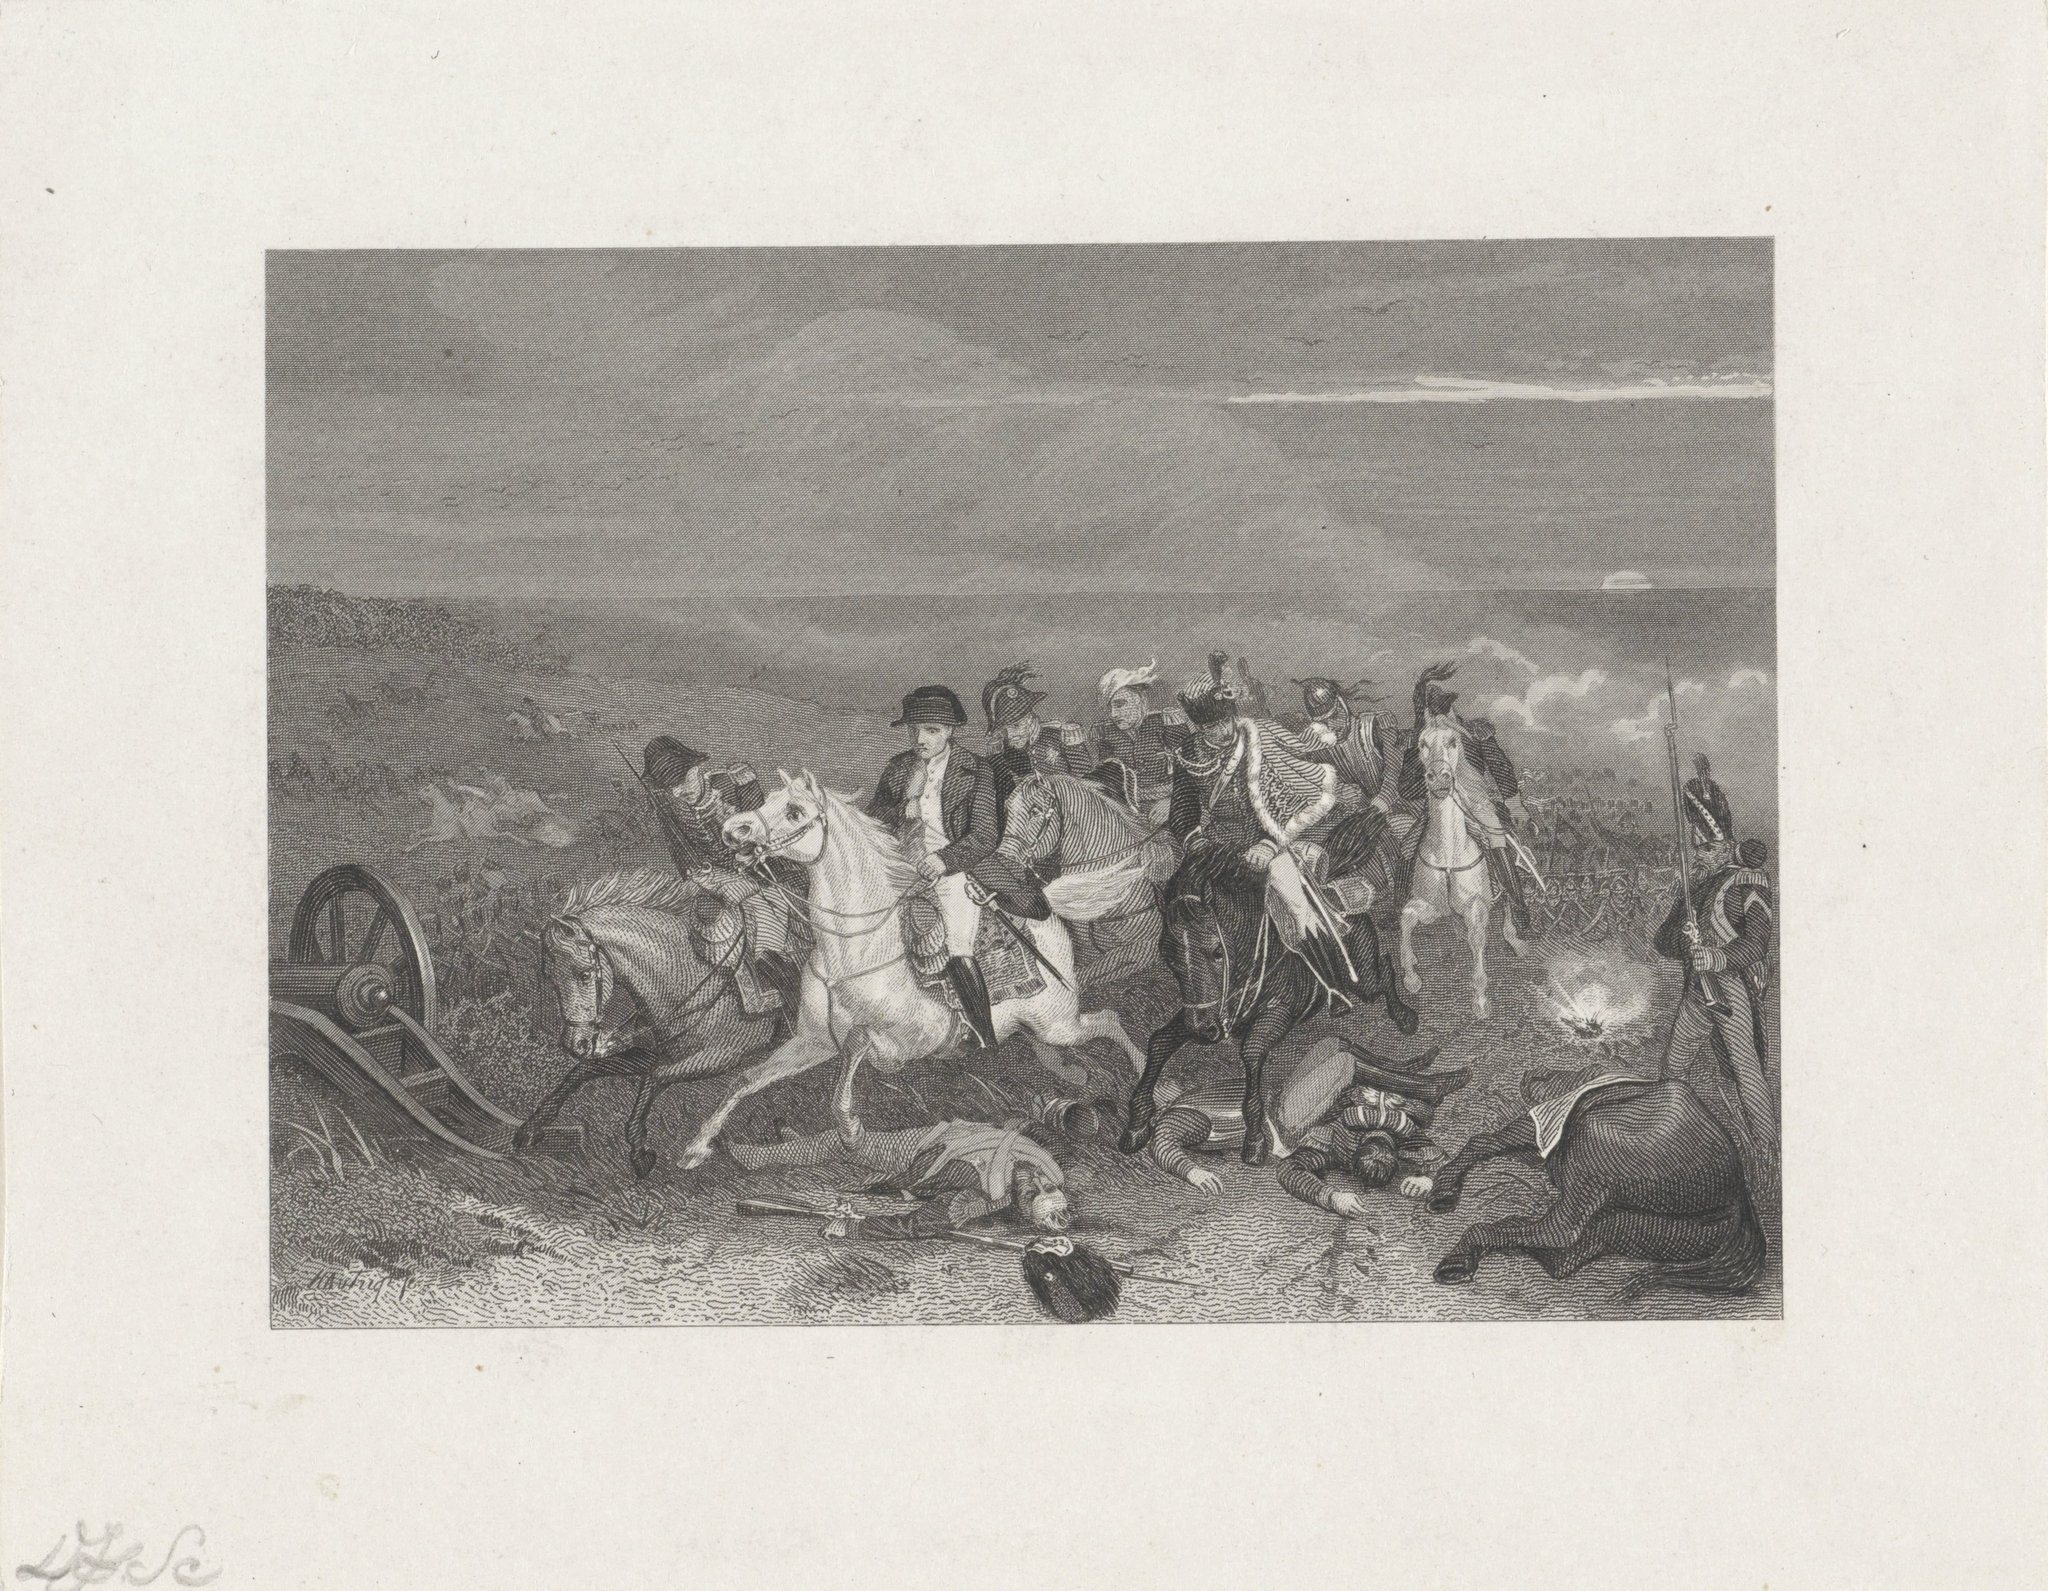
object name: print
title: Aftocht van Napoleon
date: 1826-1886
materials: paper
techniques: etching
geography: amsterdam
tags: napoleon i (emperor of the french), the defeated (after the battle)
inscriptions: collector's mark: Lugt 2228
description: Bij een ondergaande zon vlucht Napoleon met zijn adjudanten van het slagveld.